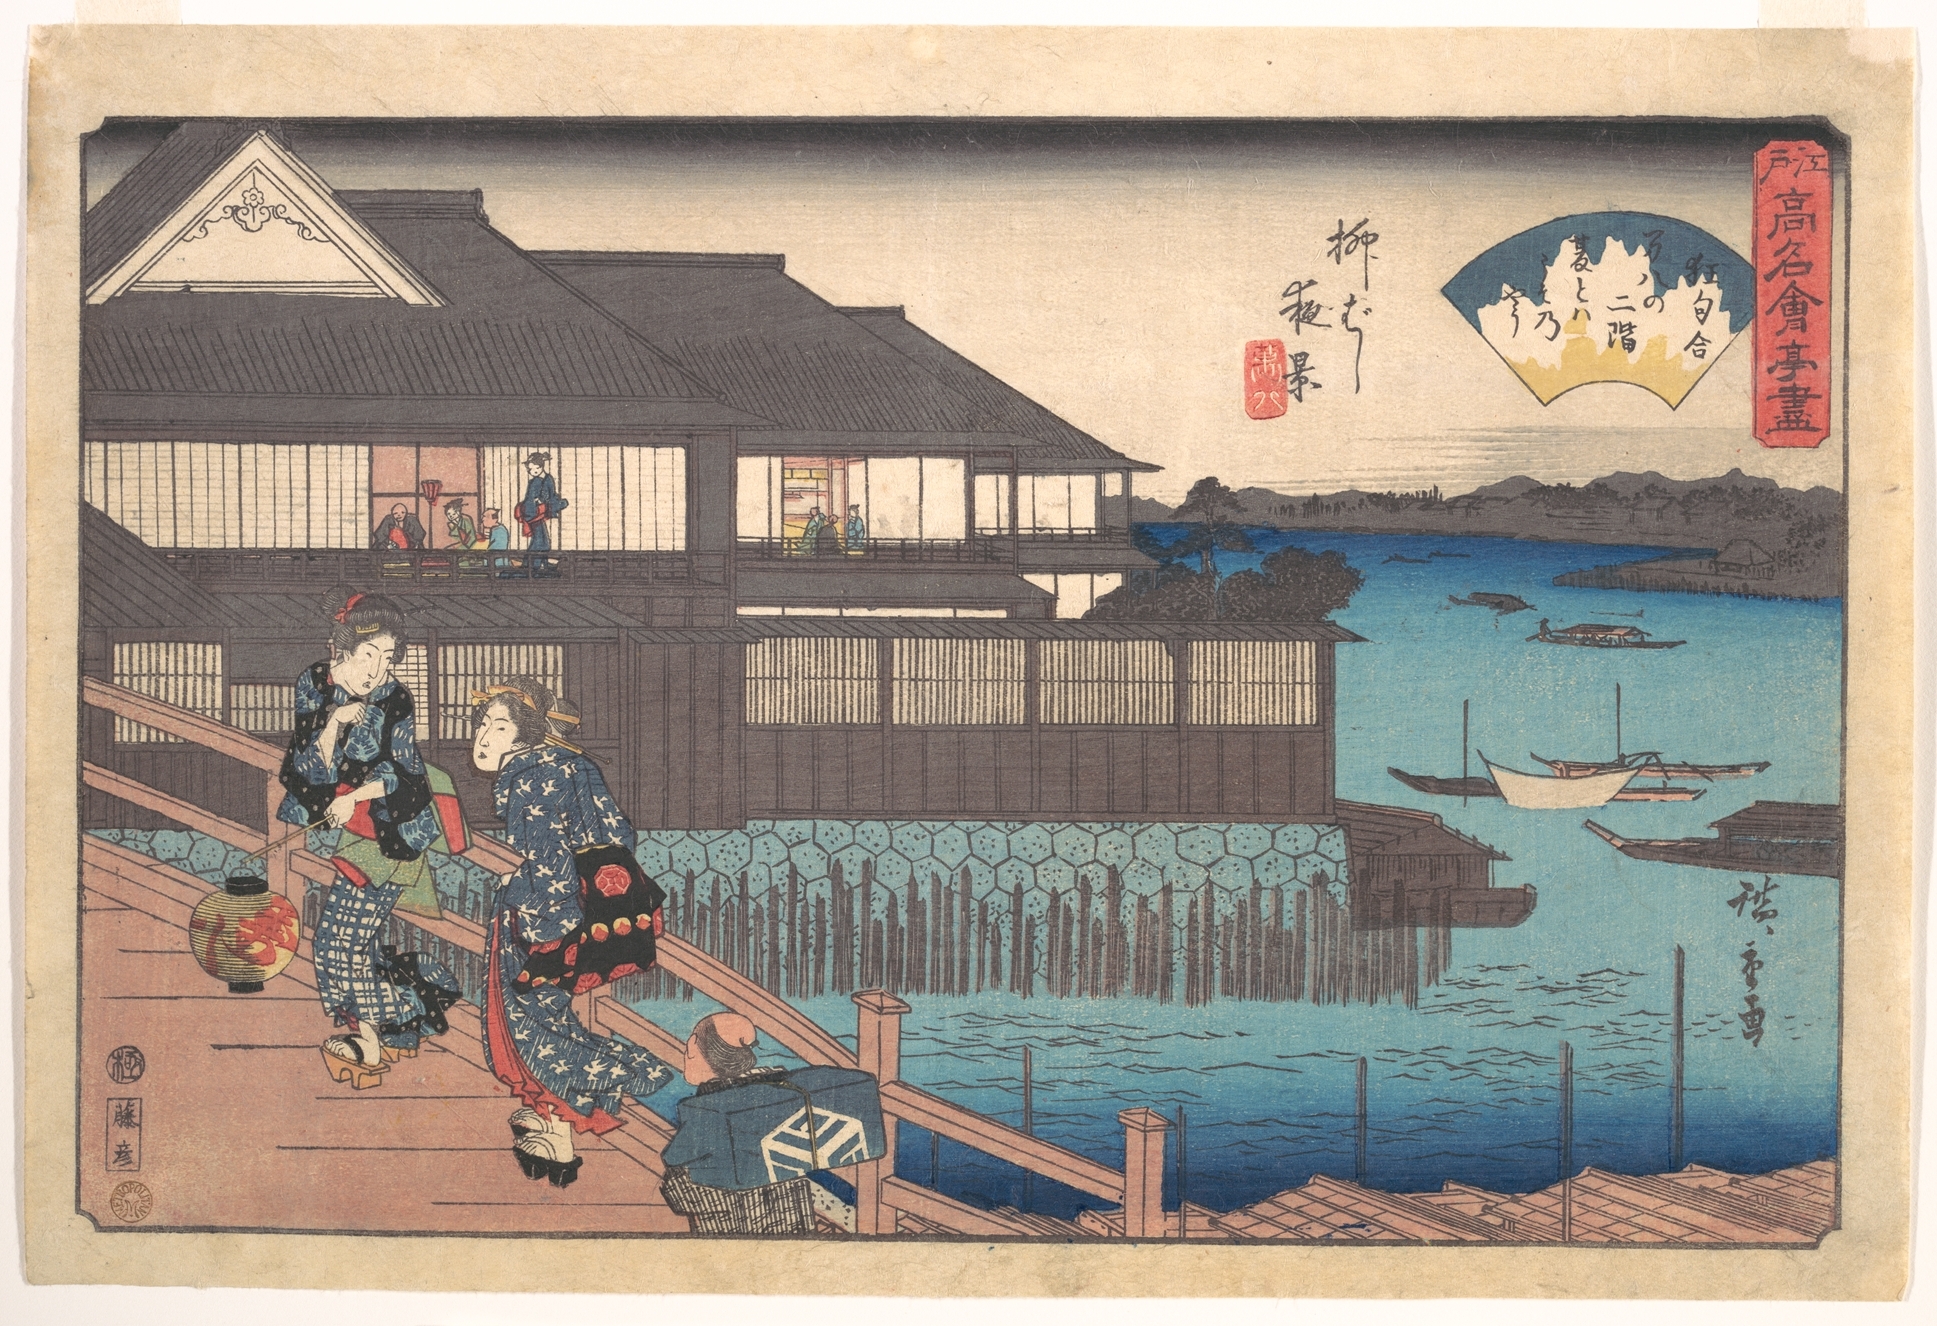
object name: print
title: The Manpachi at Evening in Yanagibashi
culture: japanese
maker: utagawa hiroshige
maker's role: artist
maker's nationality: japanese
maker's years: 1797-1858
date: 1835-1842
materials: ink, paper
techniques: woodblock print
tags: women,boats,lanterns